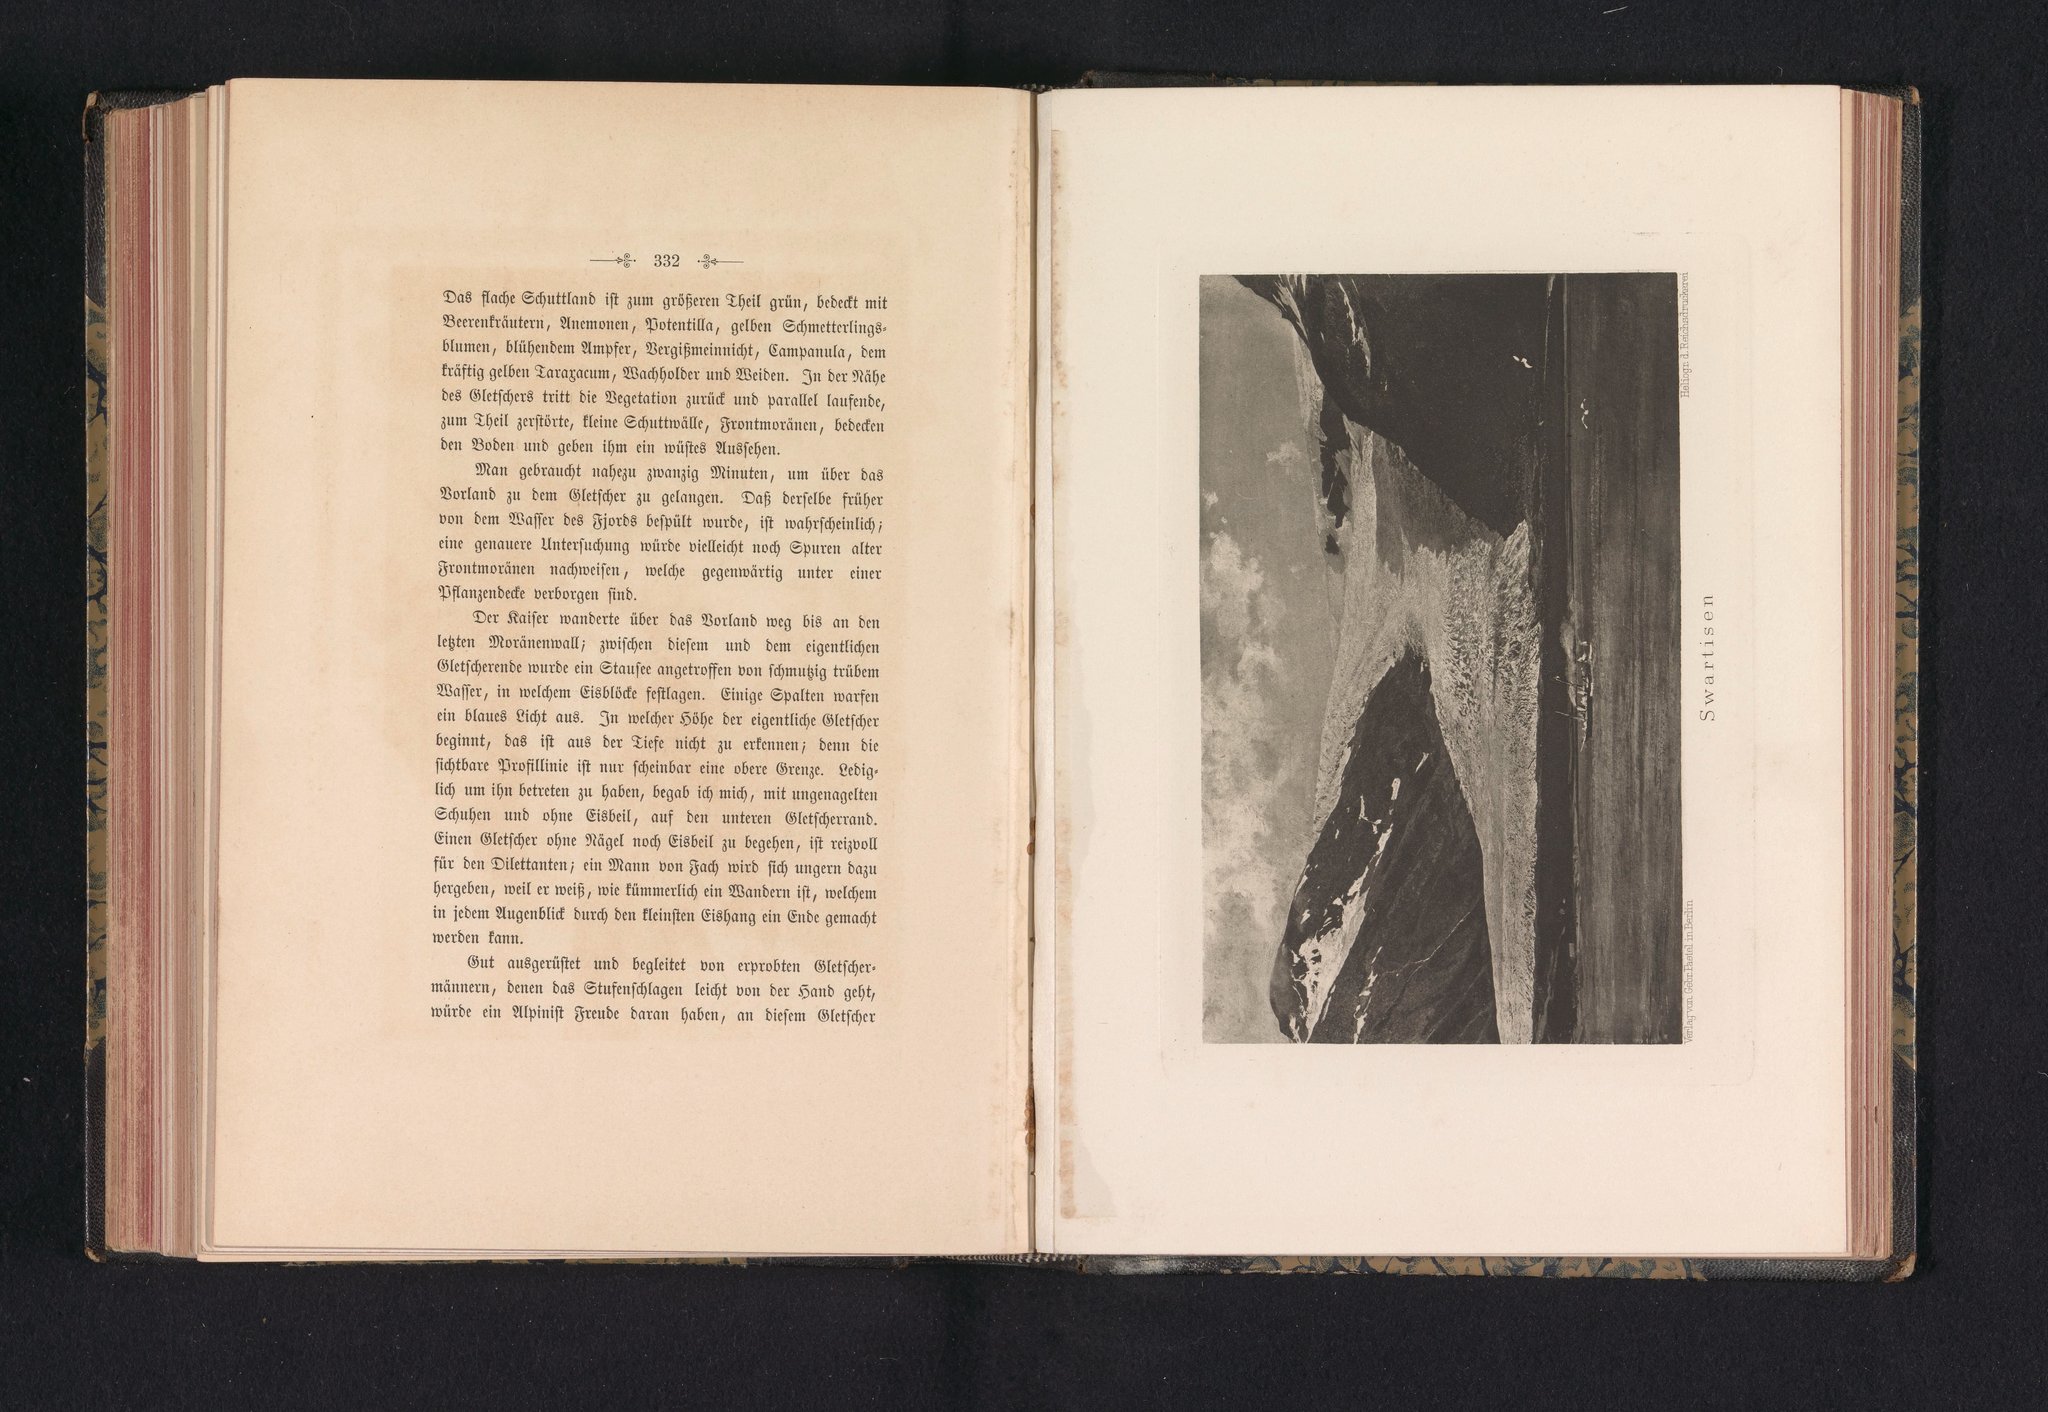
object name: photomechanical print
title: Swartisen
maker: paul güssfeldt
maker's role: alpinist, wiskundige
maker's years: 1840-1920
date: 1889-1892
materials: paper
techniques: photoaquatint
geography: berlin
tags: glacier